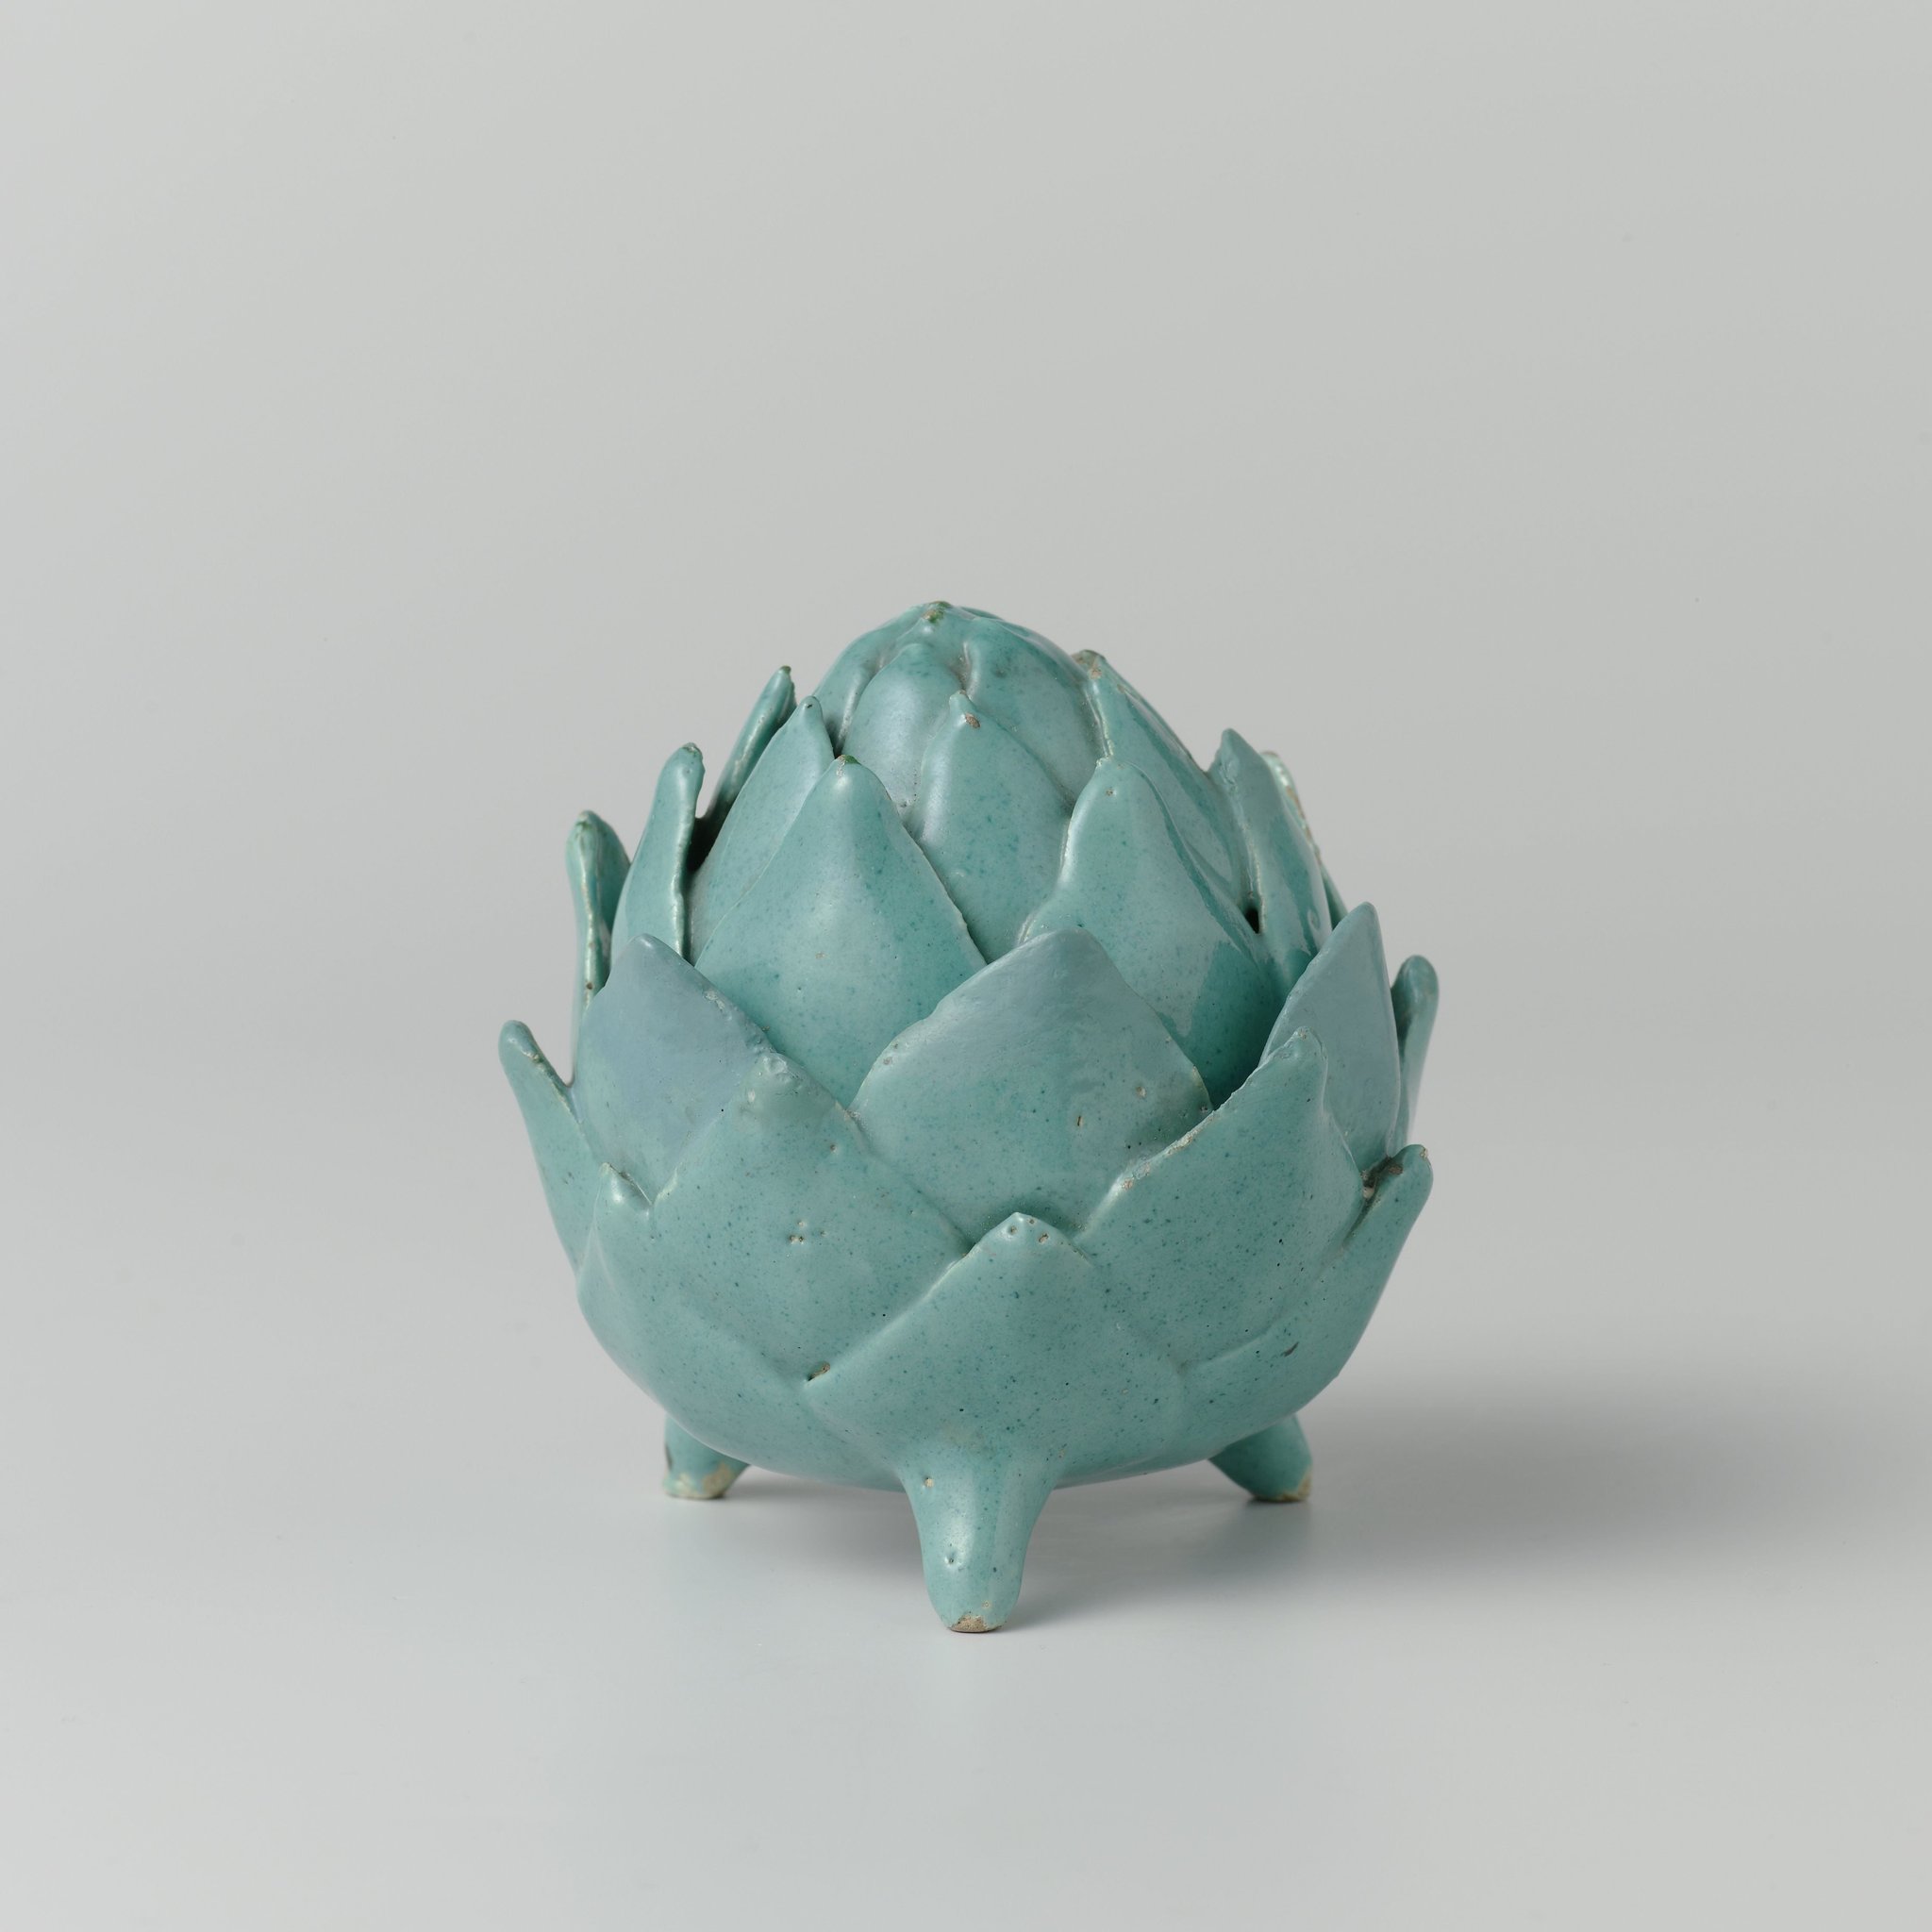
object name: butter dish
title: Botervloot van faience in de vorm van een artisjok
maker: Anonymous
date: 1740-1775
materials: earthenware, glaze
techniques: painted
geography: delft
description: Botervloot van groen gekleurde faience in de vorm van een artisjok.